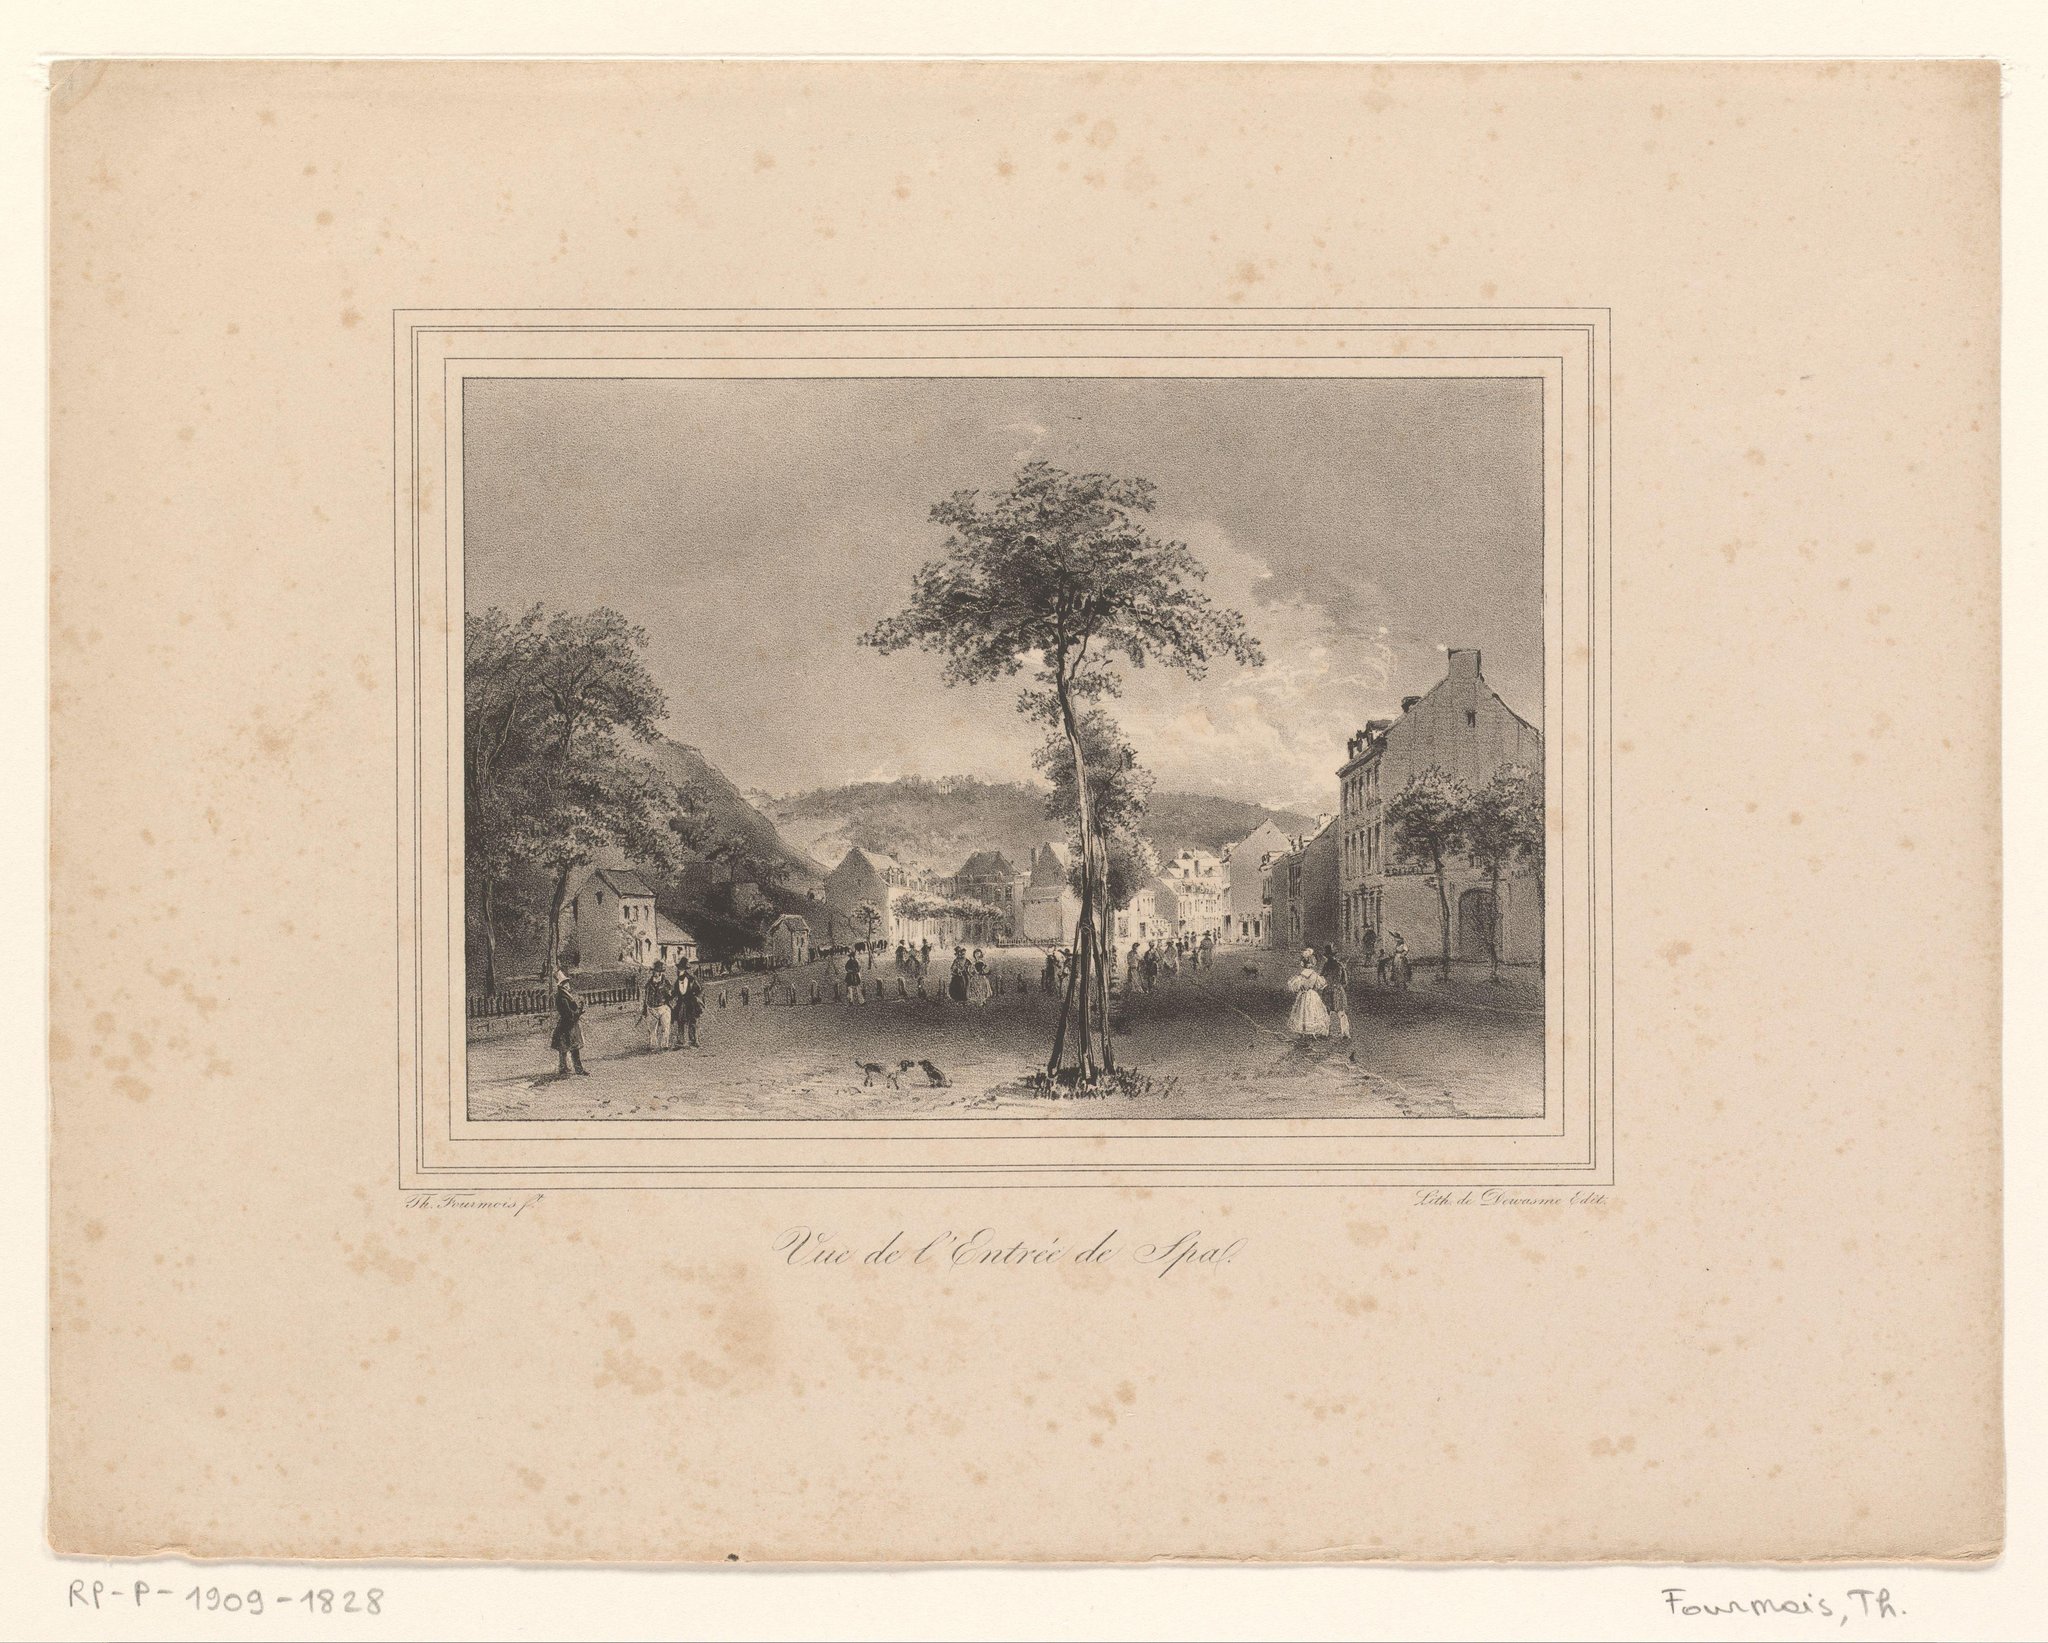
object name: print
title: Gezicht op Spa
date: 1833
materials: paper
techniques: lithograph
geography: brussels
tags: city-view in general; 'veduta' (+ city(-scape) with figures, staffage), public road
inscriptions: collector's mark: Lugt 2228